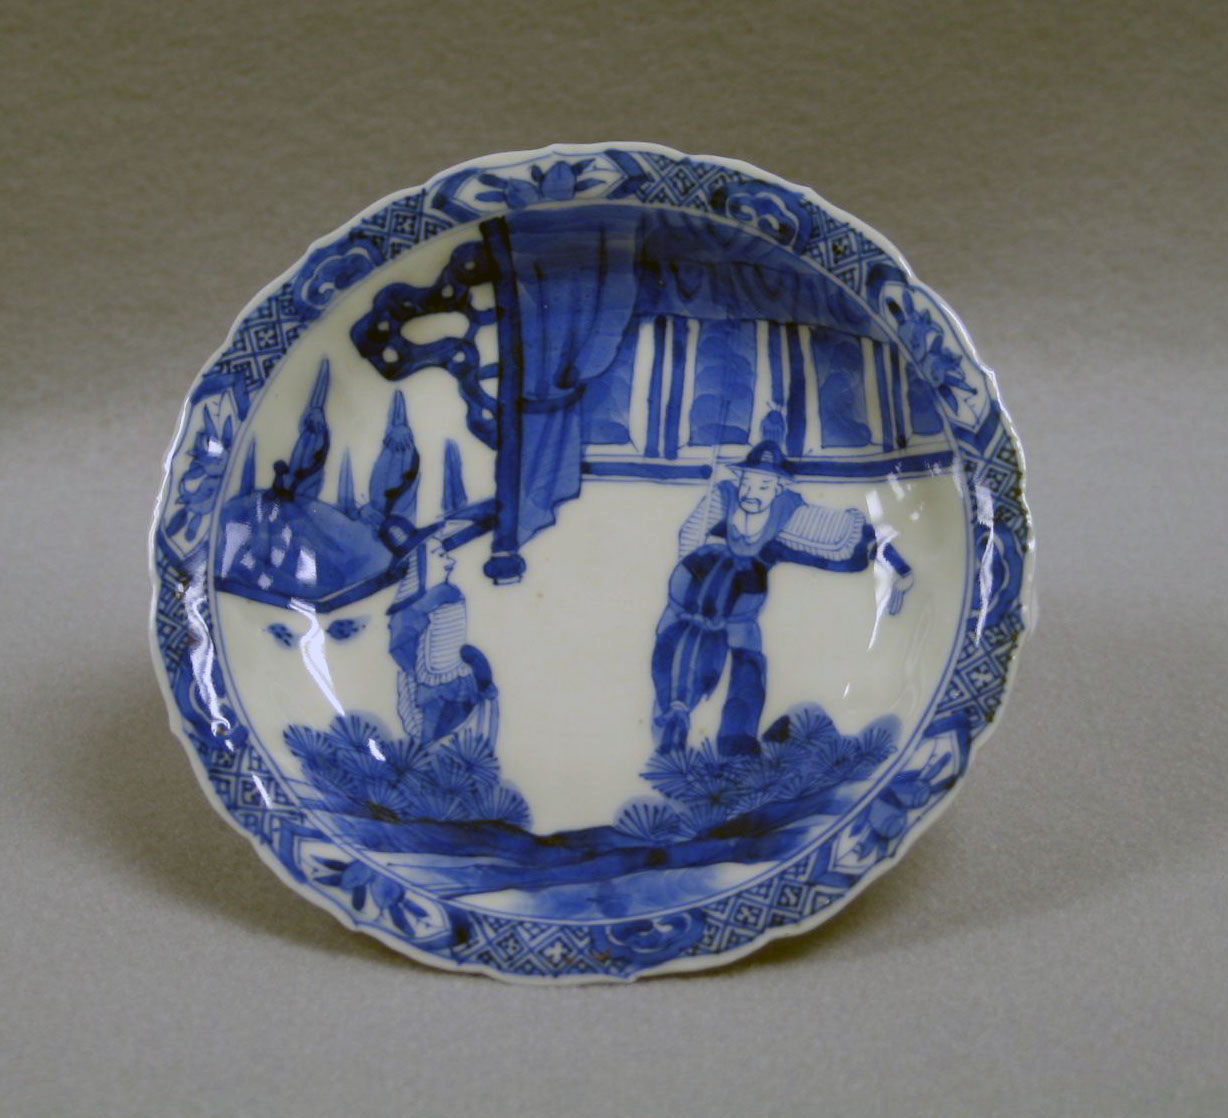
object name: dish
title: Dish with figures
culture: japanese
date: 1800-1912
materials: cobalt, glaze, porcelain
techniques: painting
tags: men